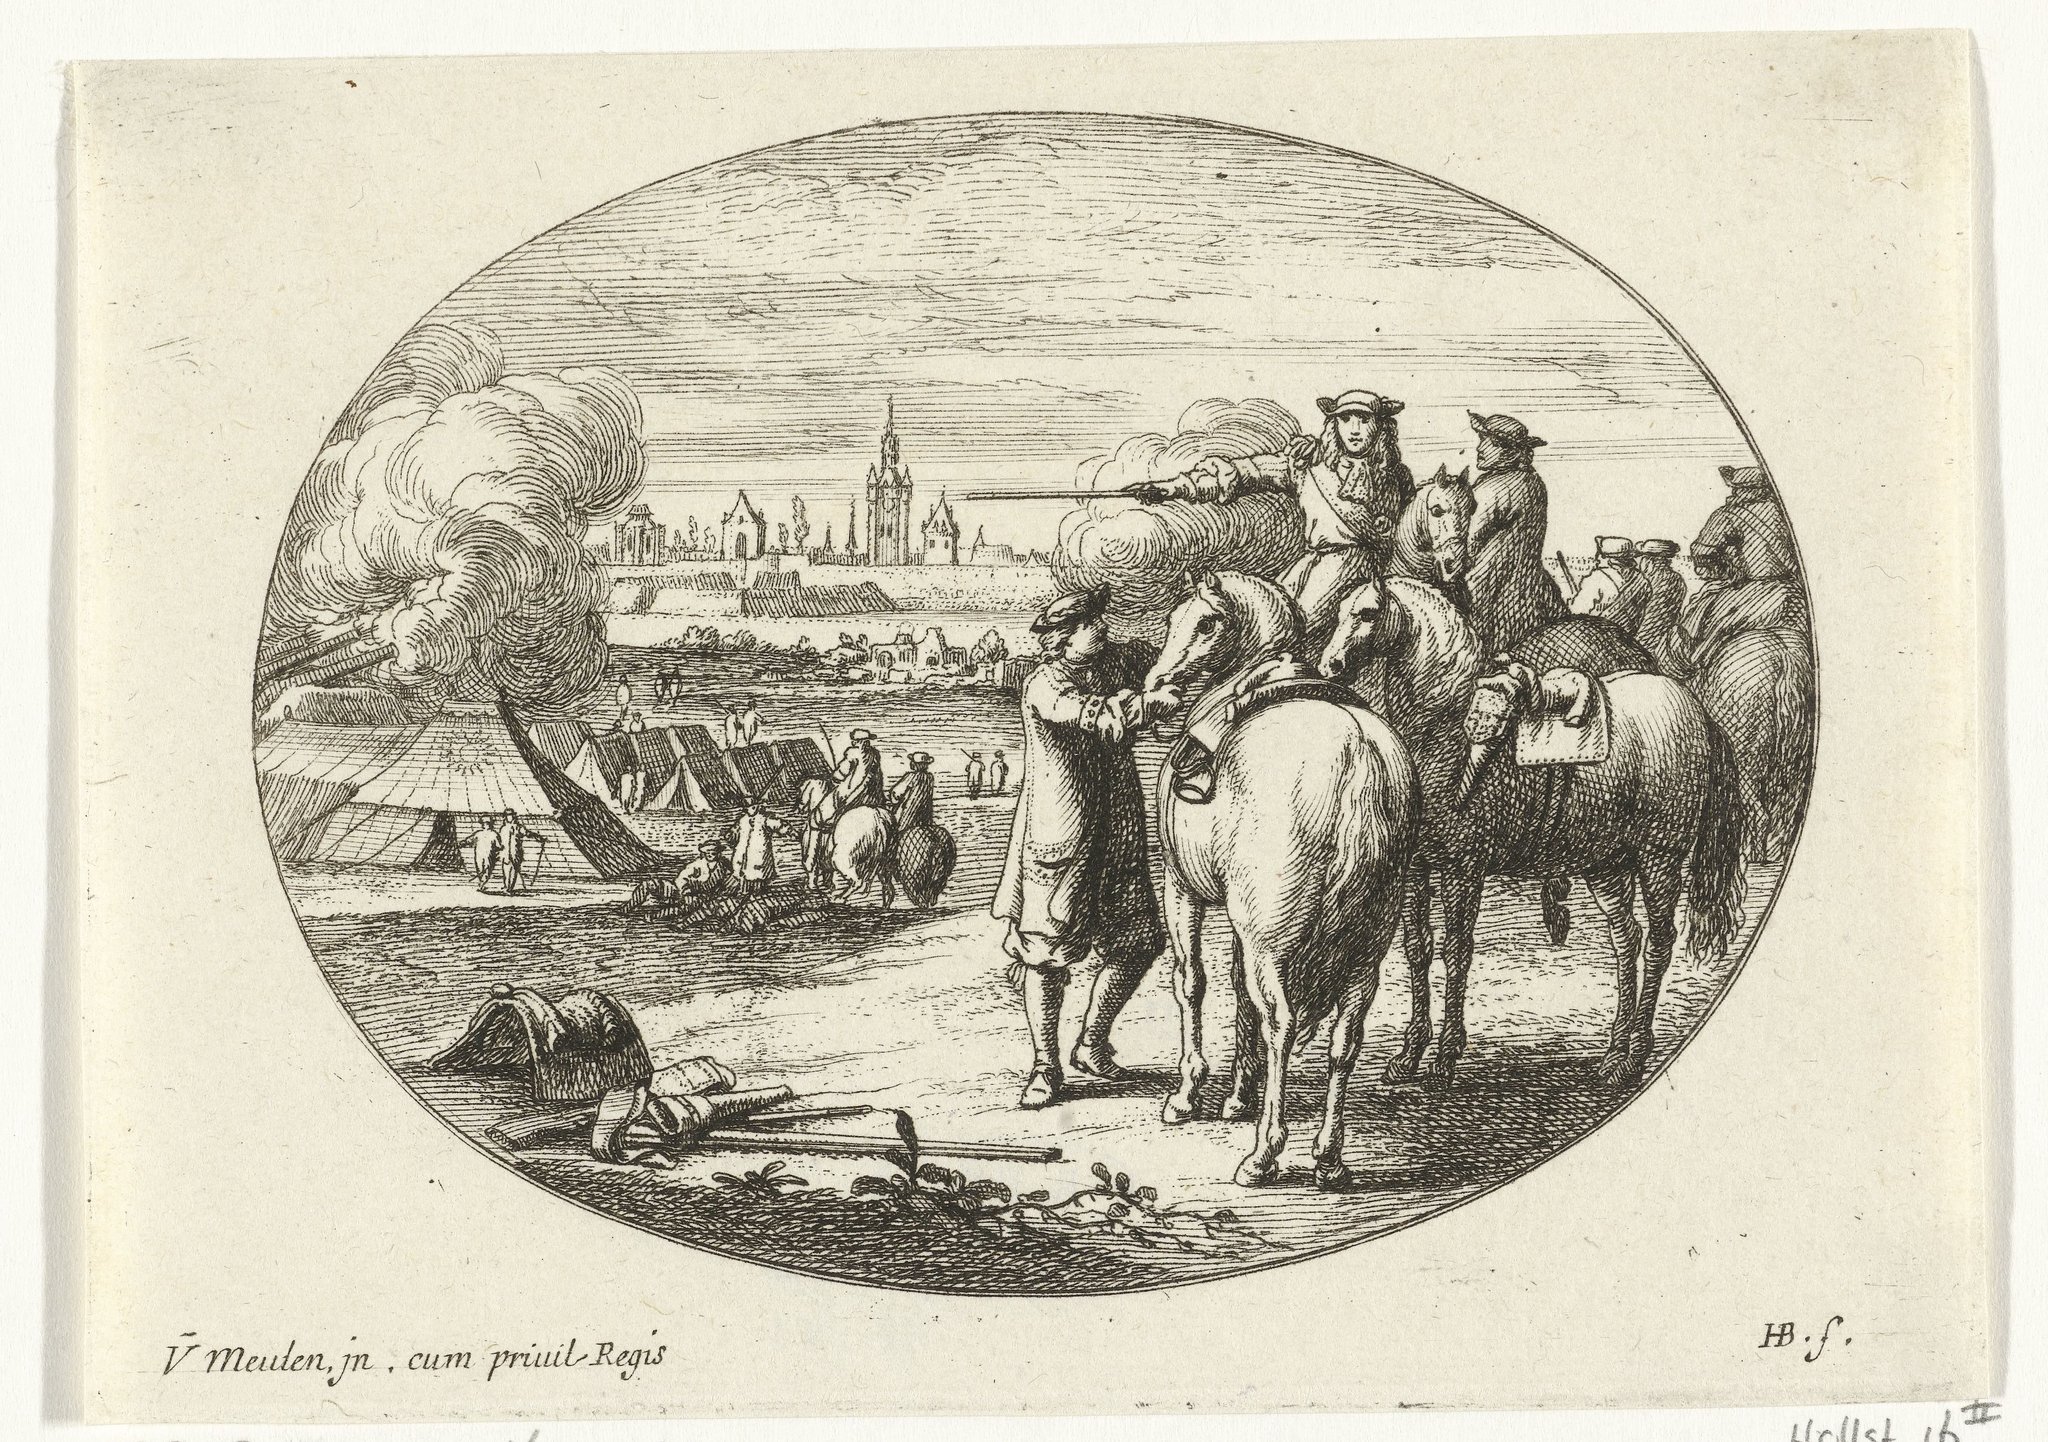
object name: print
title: Militaire voorstellingen uit het leven van Lodewijk XIV, koning van Frankrijk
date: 1674-1733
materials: paper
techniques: etching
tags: lodewijk xiv (koning van frankrijk), historical persons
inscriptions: collector's mark: Lugt 2228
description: Rechts ruiters en paarden, één ruiter wijst. Links een legerkamp, kanonnen en aan de horizon een stad.